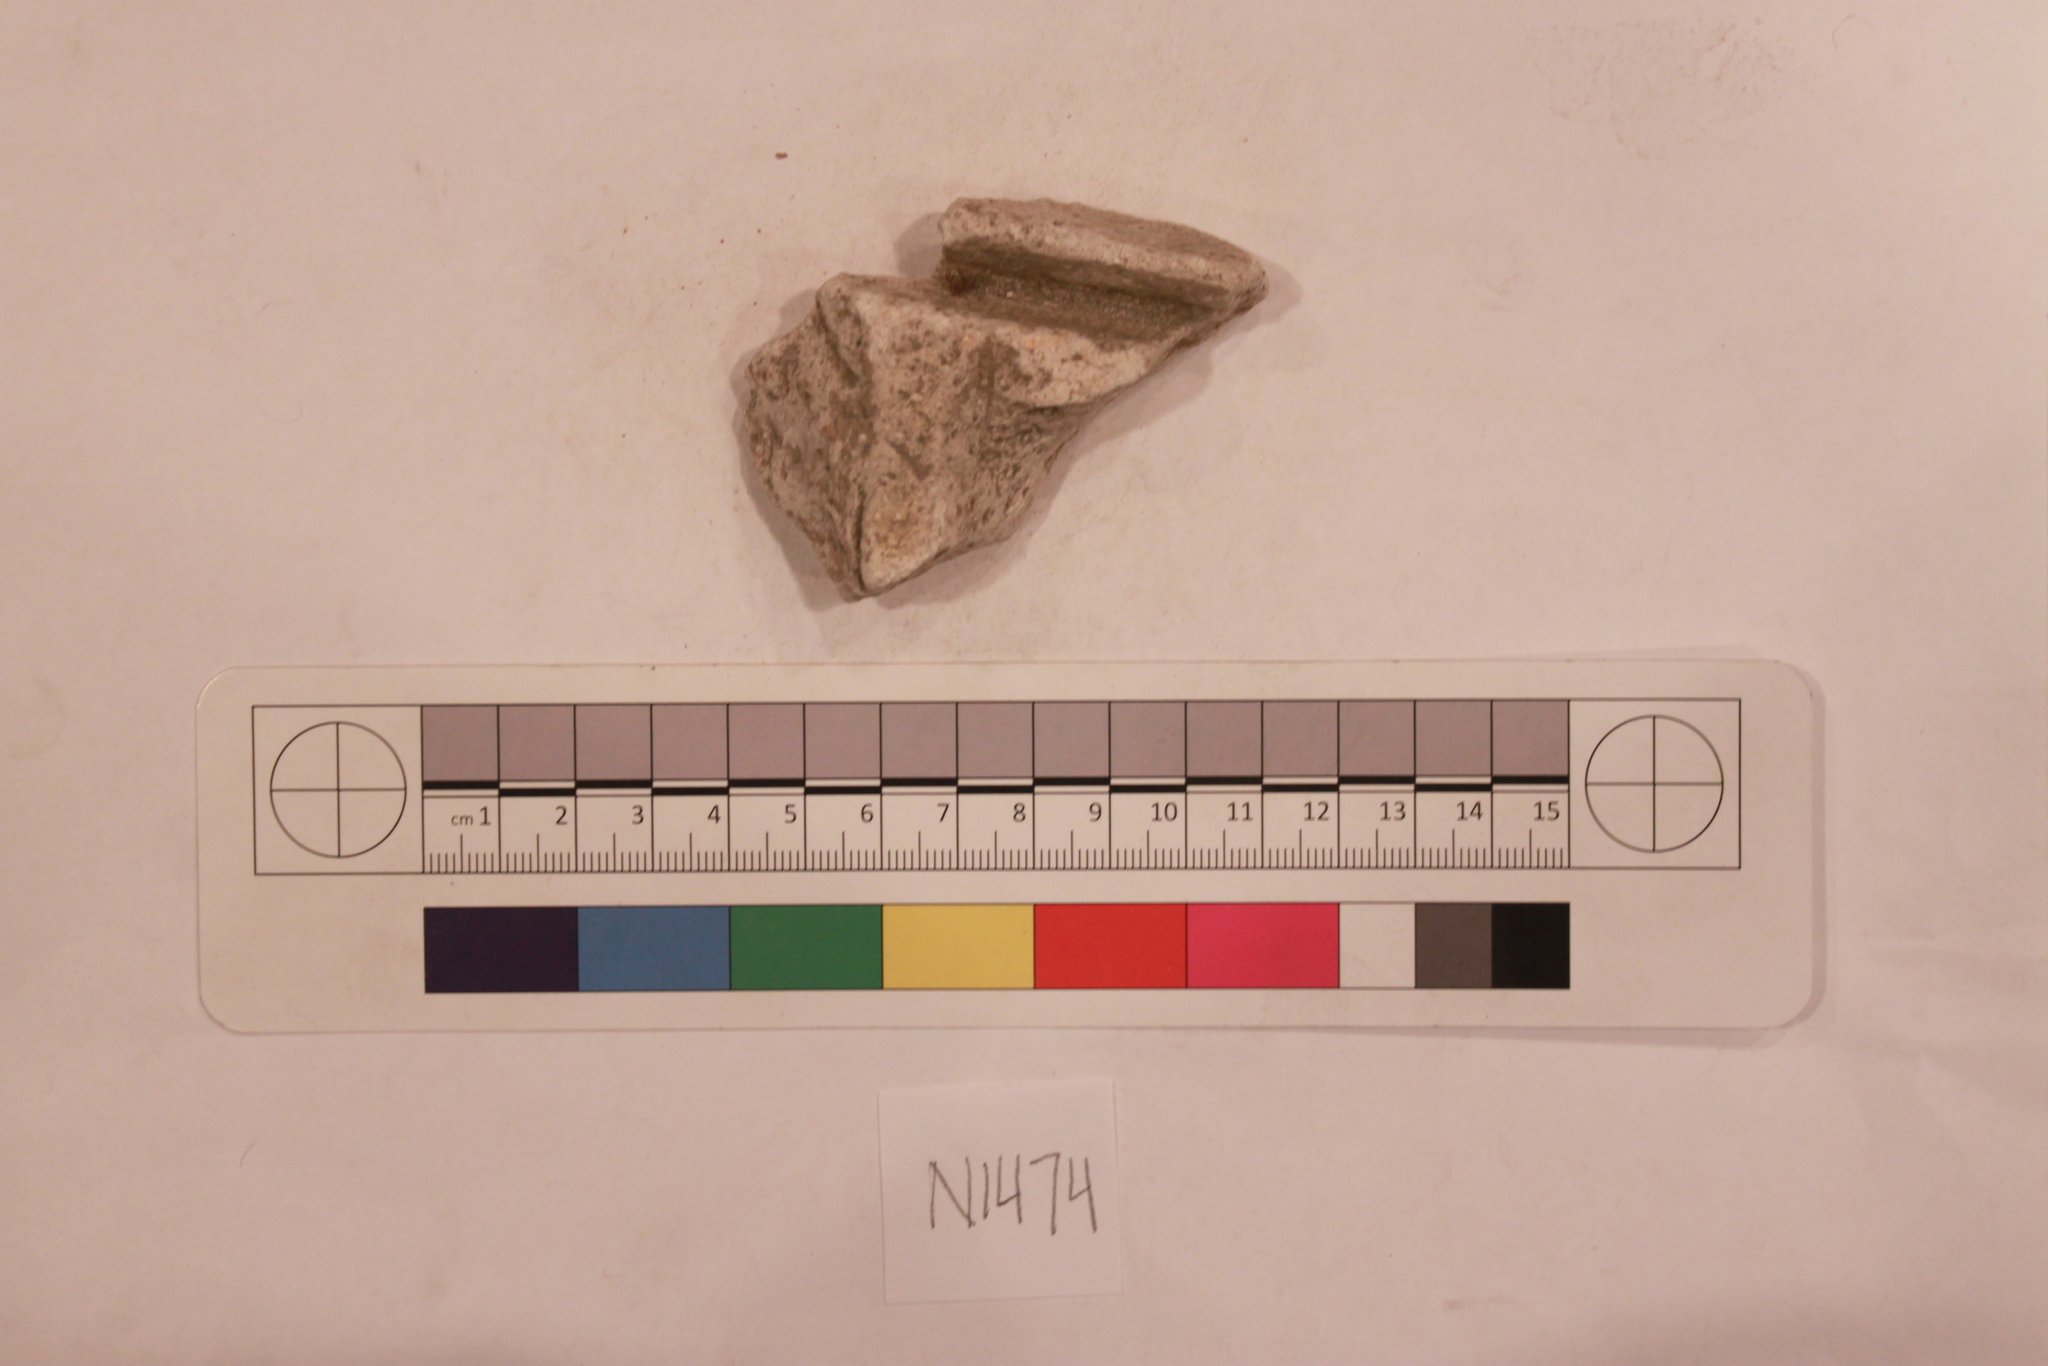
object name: fragment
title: Stucco Fragment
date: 701-1200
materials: plaster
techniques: carving, painting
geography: iran